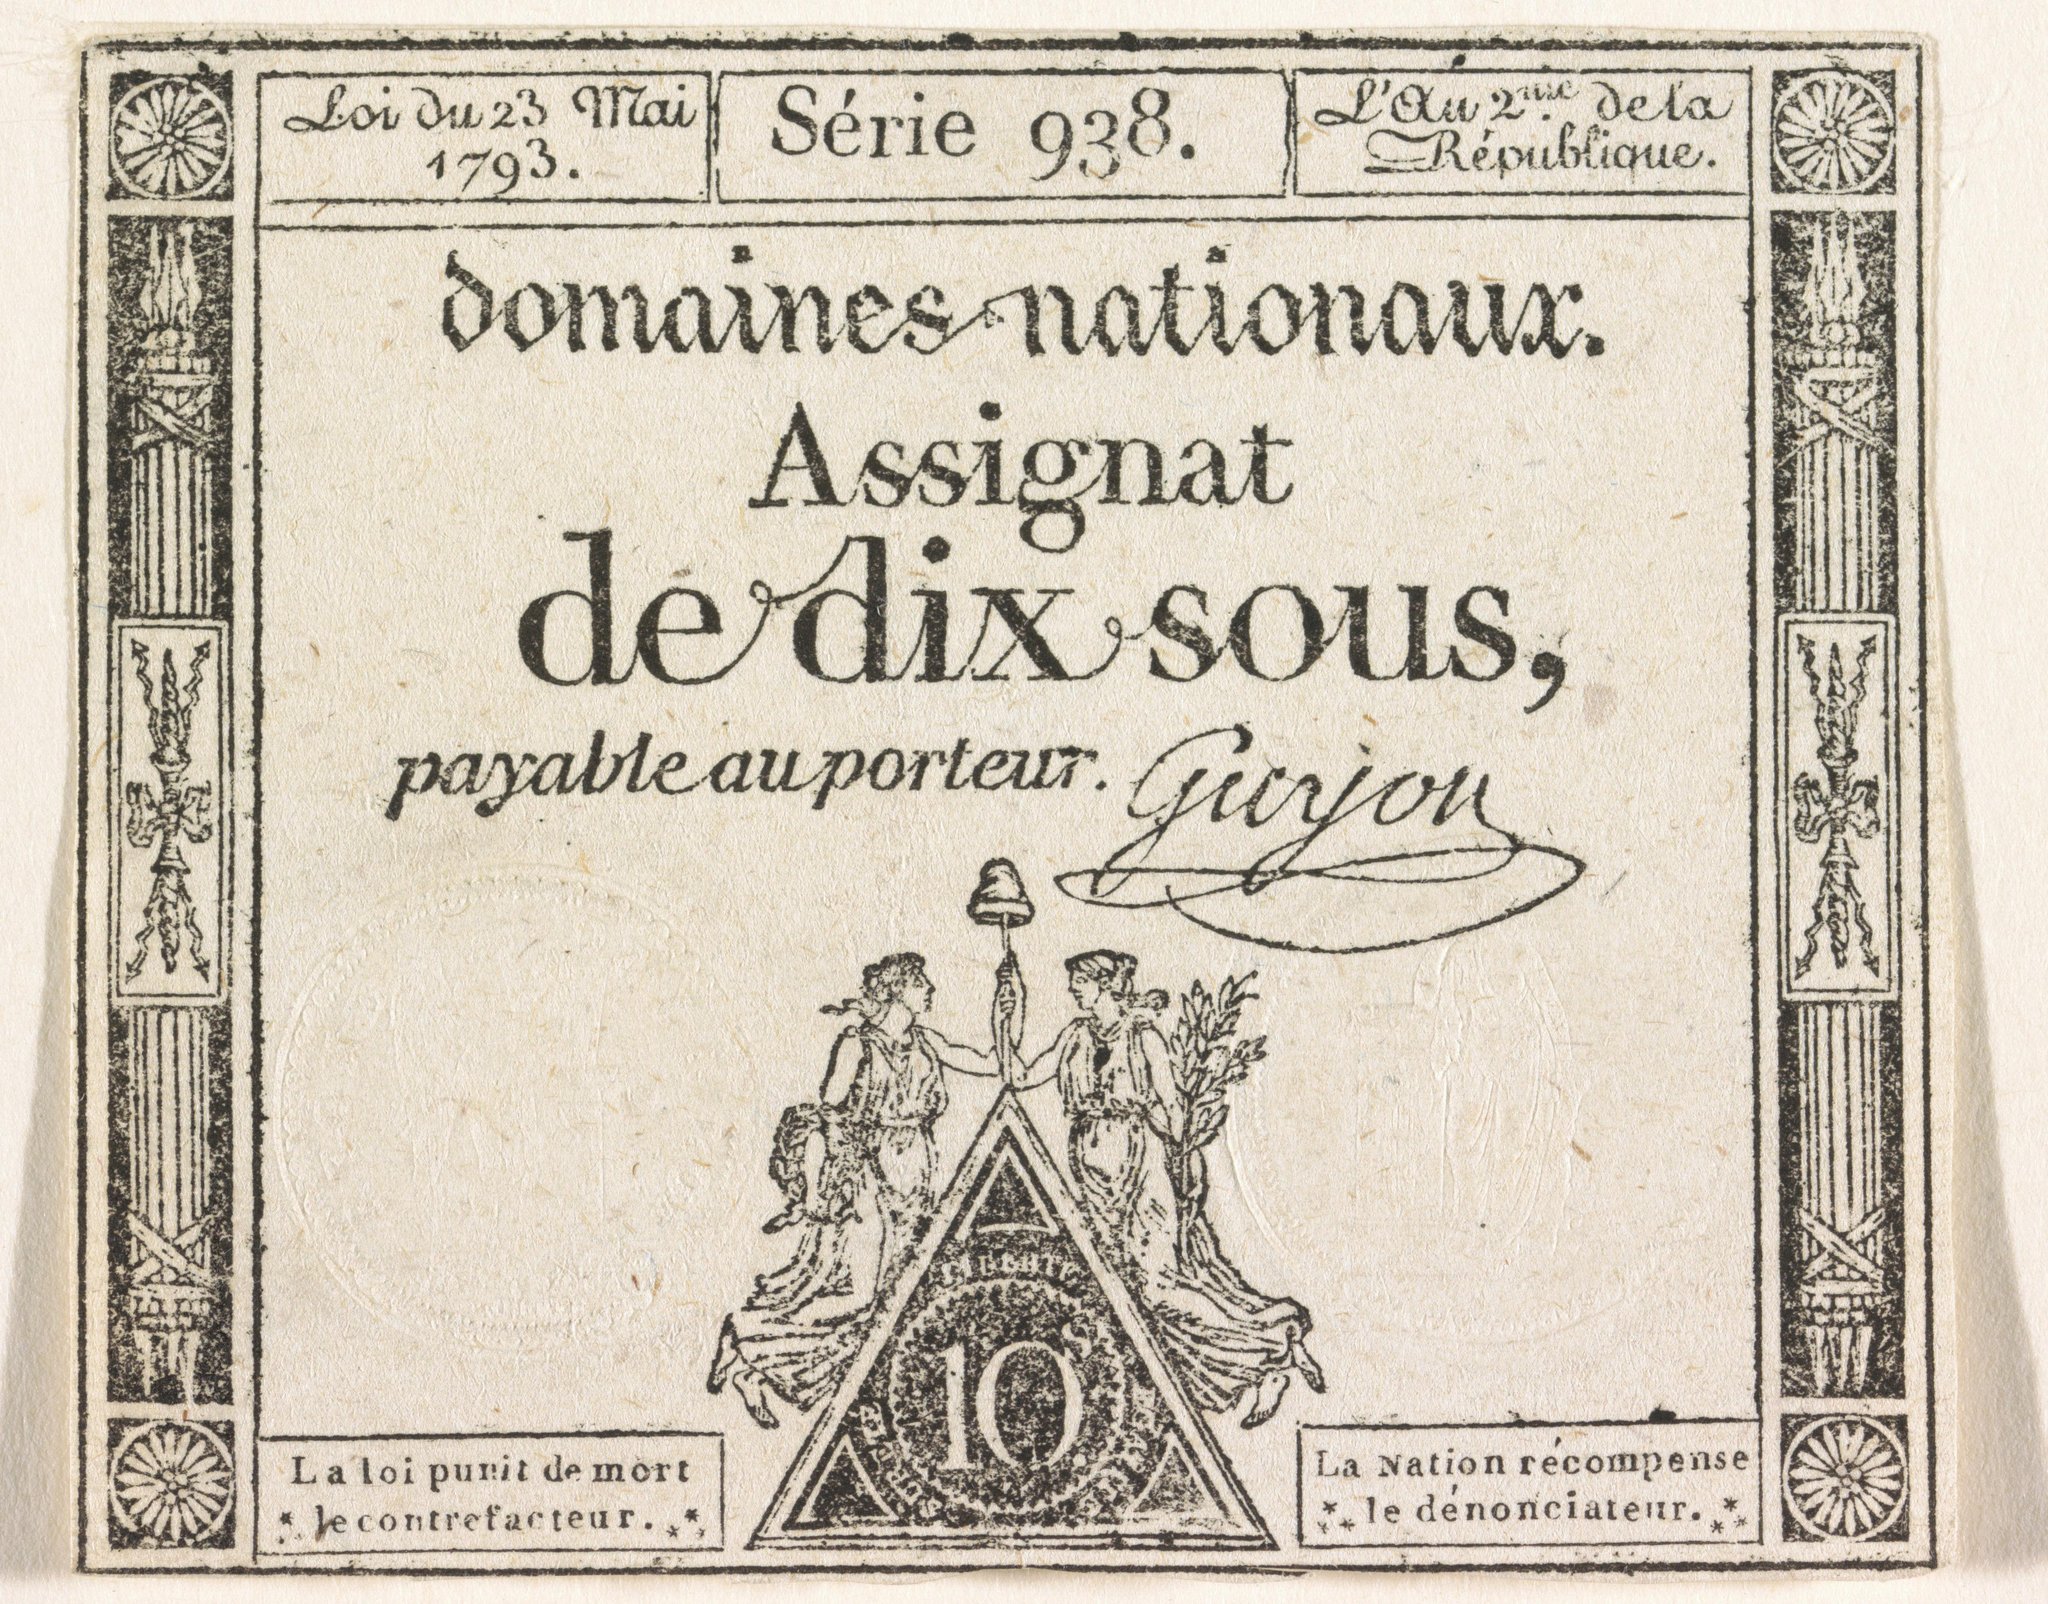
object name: assignat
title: Asignaat van 10 sous, 1793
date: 1793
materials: paper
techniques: blind stamped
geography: france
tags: bank-note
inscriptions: collector's mark: Lugt 2228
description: Franse assignaat van 10 sous. In omloop gebracht door de Domaines Nationaux, serie 938, volgens de wet van 23 mei 1793.